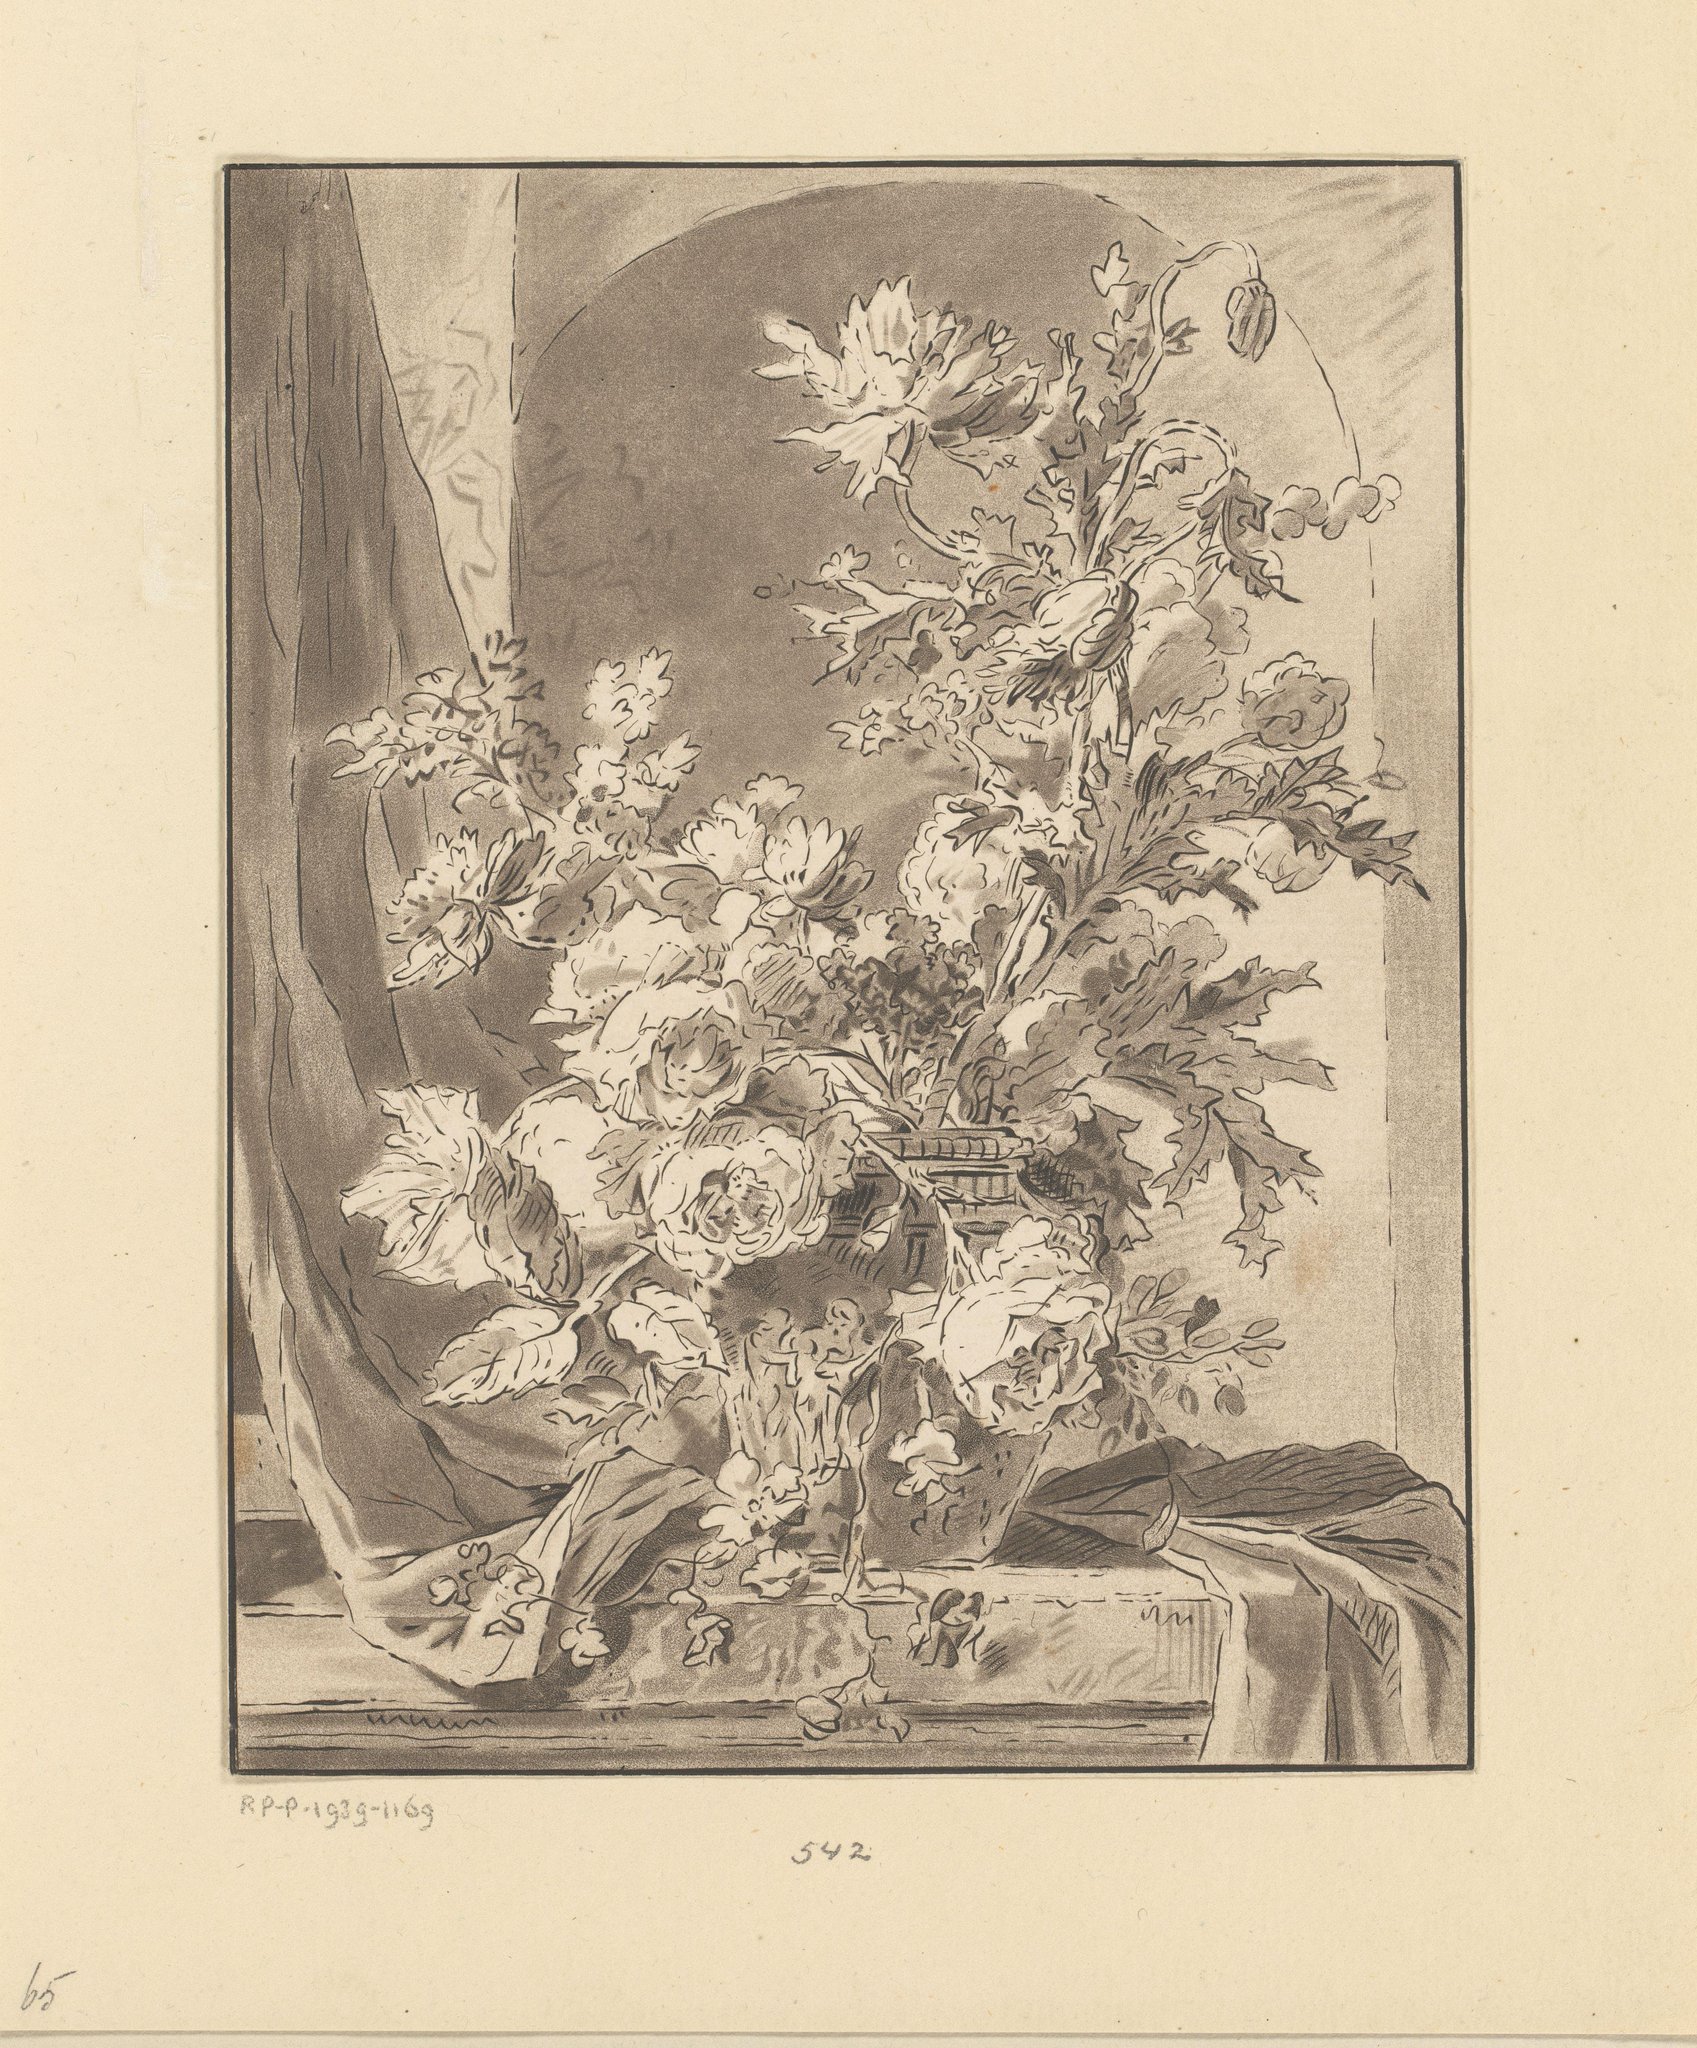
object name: print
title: Vaas met bloemen voor een nis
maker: bernhard schreuder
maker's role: print maker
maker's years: -1780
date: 1767-1780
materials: paper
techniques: etching, rocker stamped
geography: netherlands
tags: flowers in a vase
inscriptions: collector's mark: ‘RIJKS / MUSM’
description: De prent ligt los in een album, zie blad H. 65.